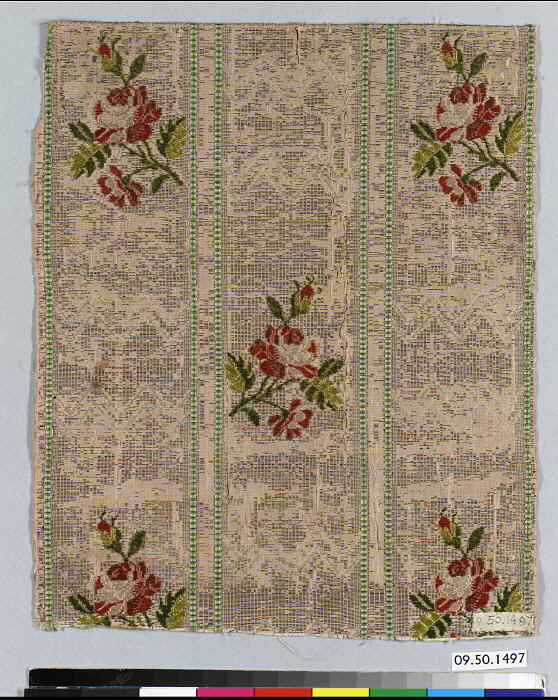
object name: piece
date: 1701-1800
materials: metal thread, silk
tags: flowers,leaves